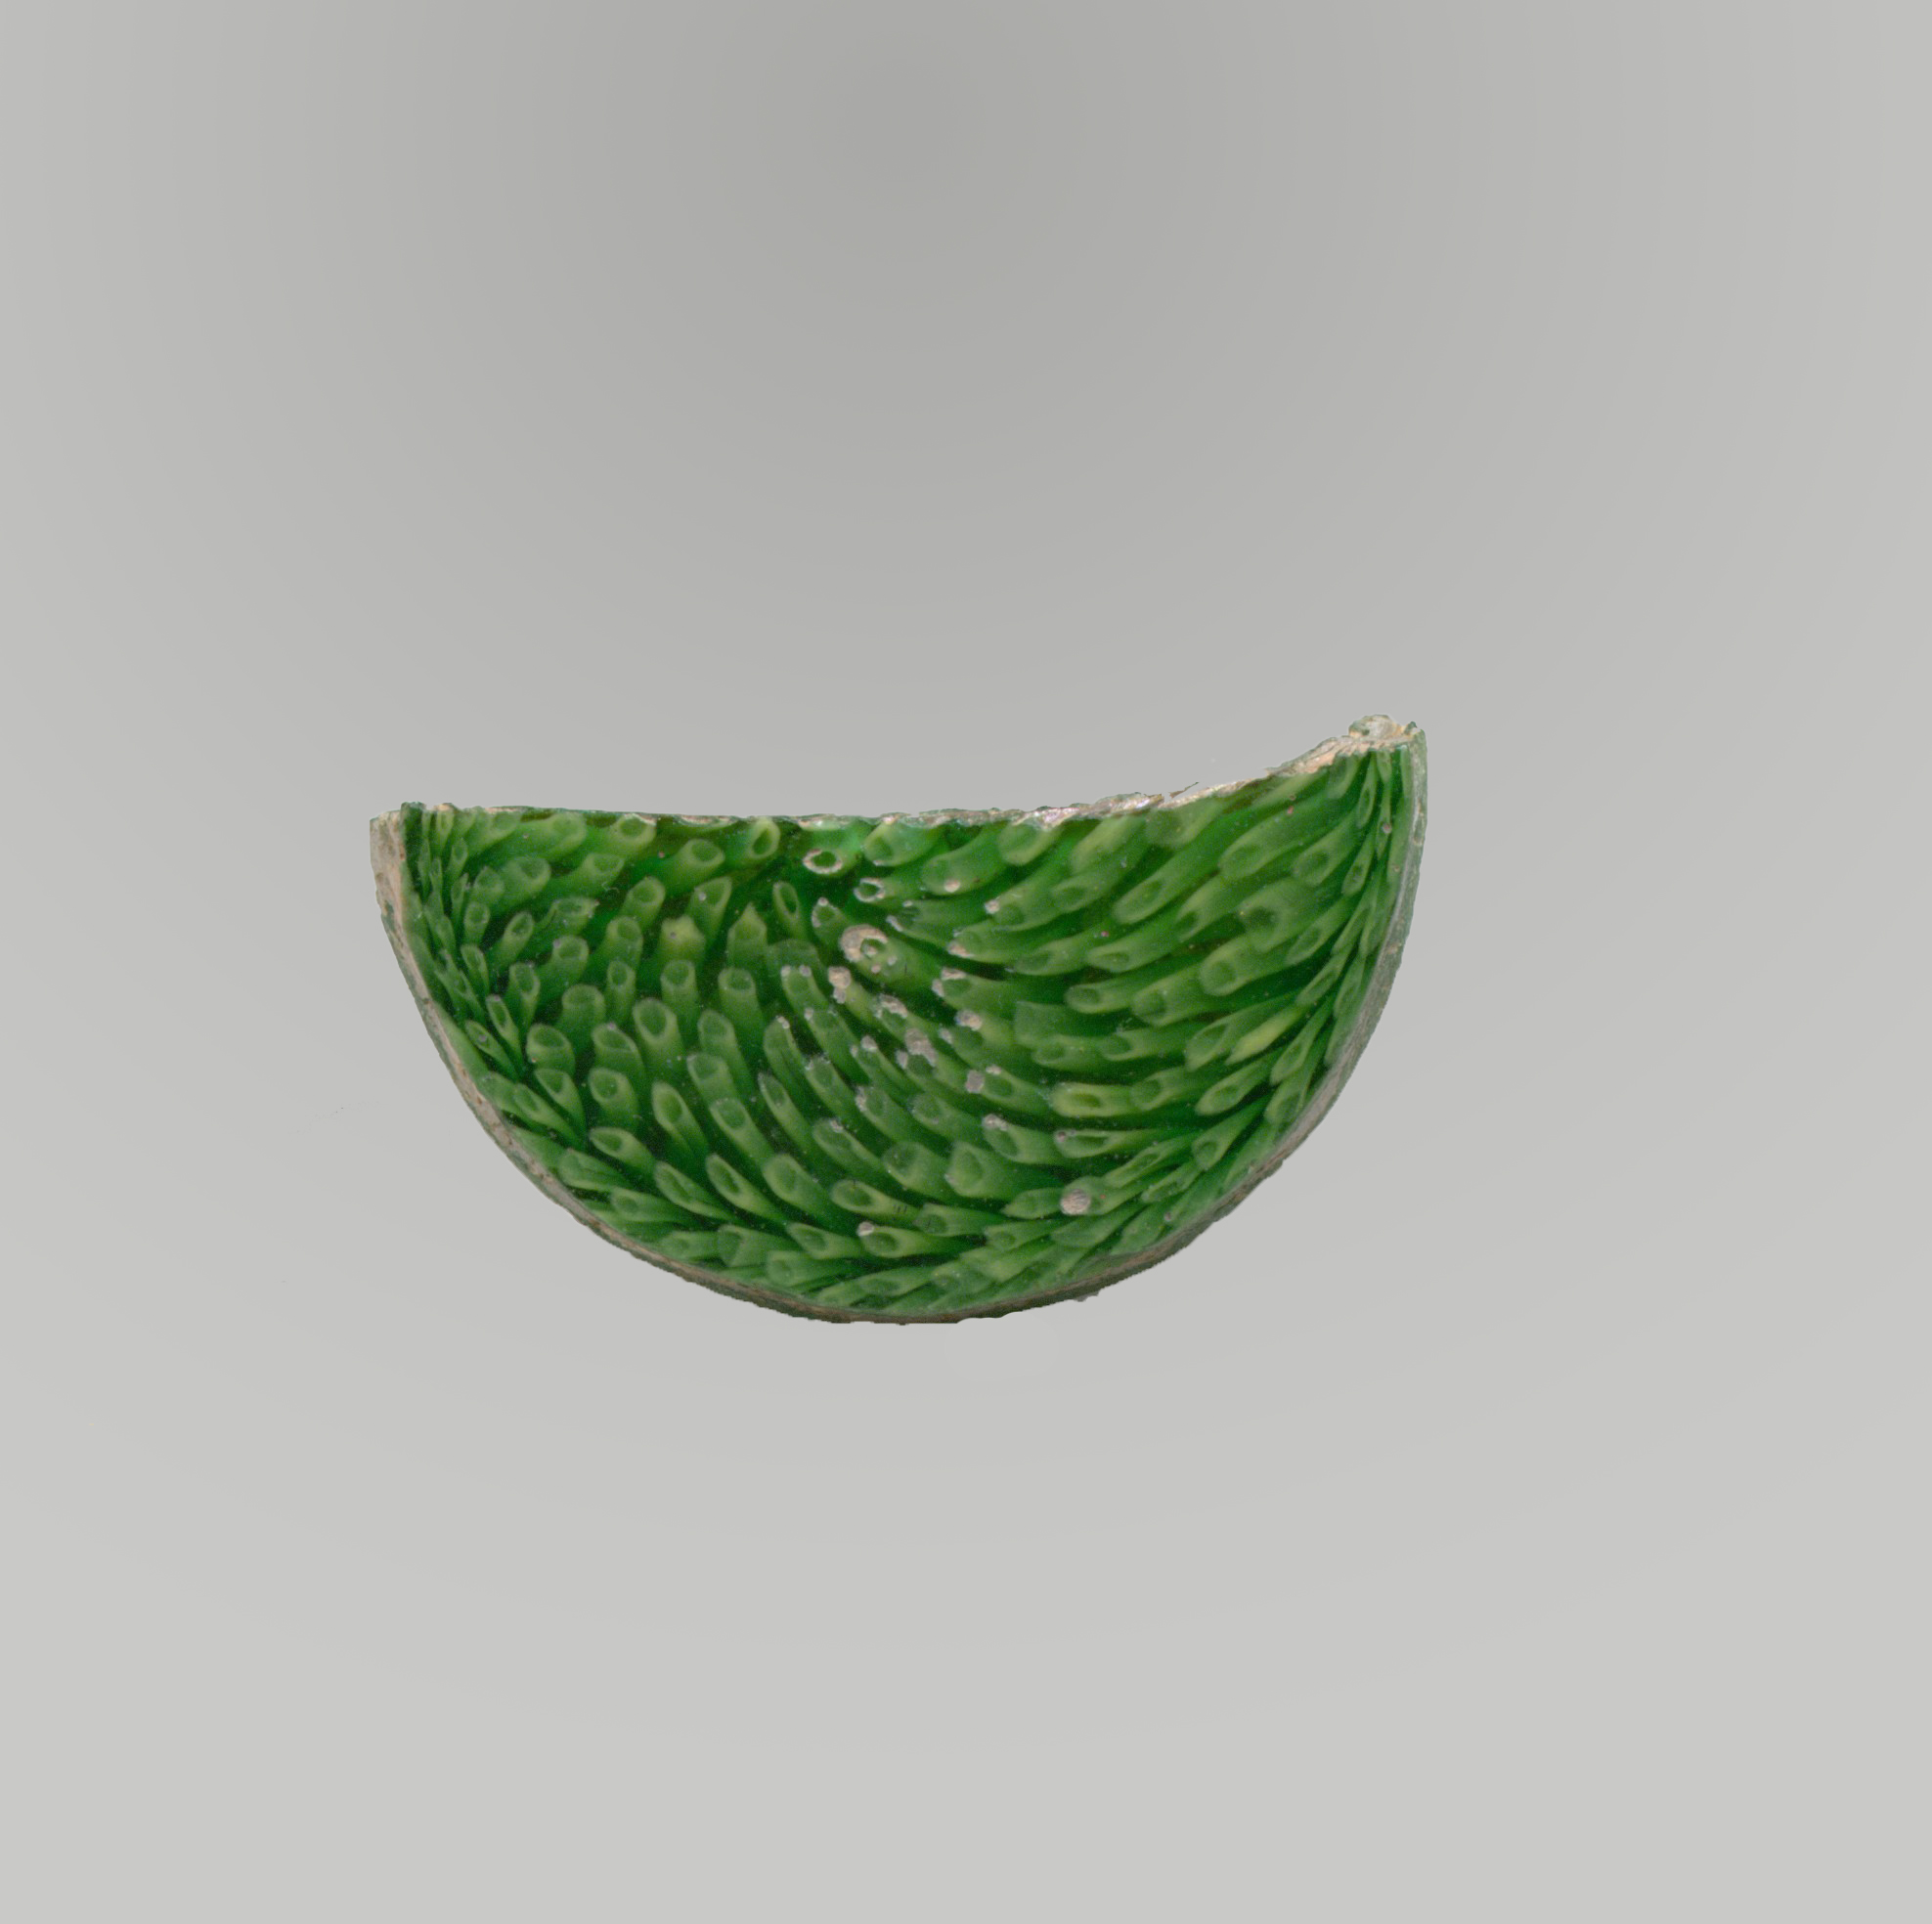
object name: fragment, mosaic base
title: Glass mosaic bowl fragment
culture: roman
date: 34 BCE-33 CE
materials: glass